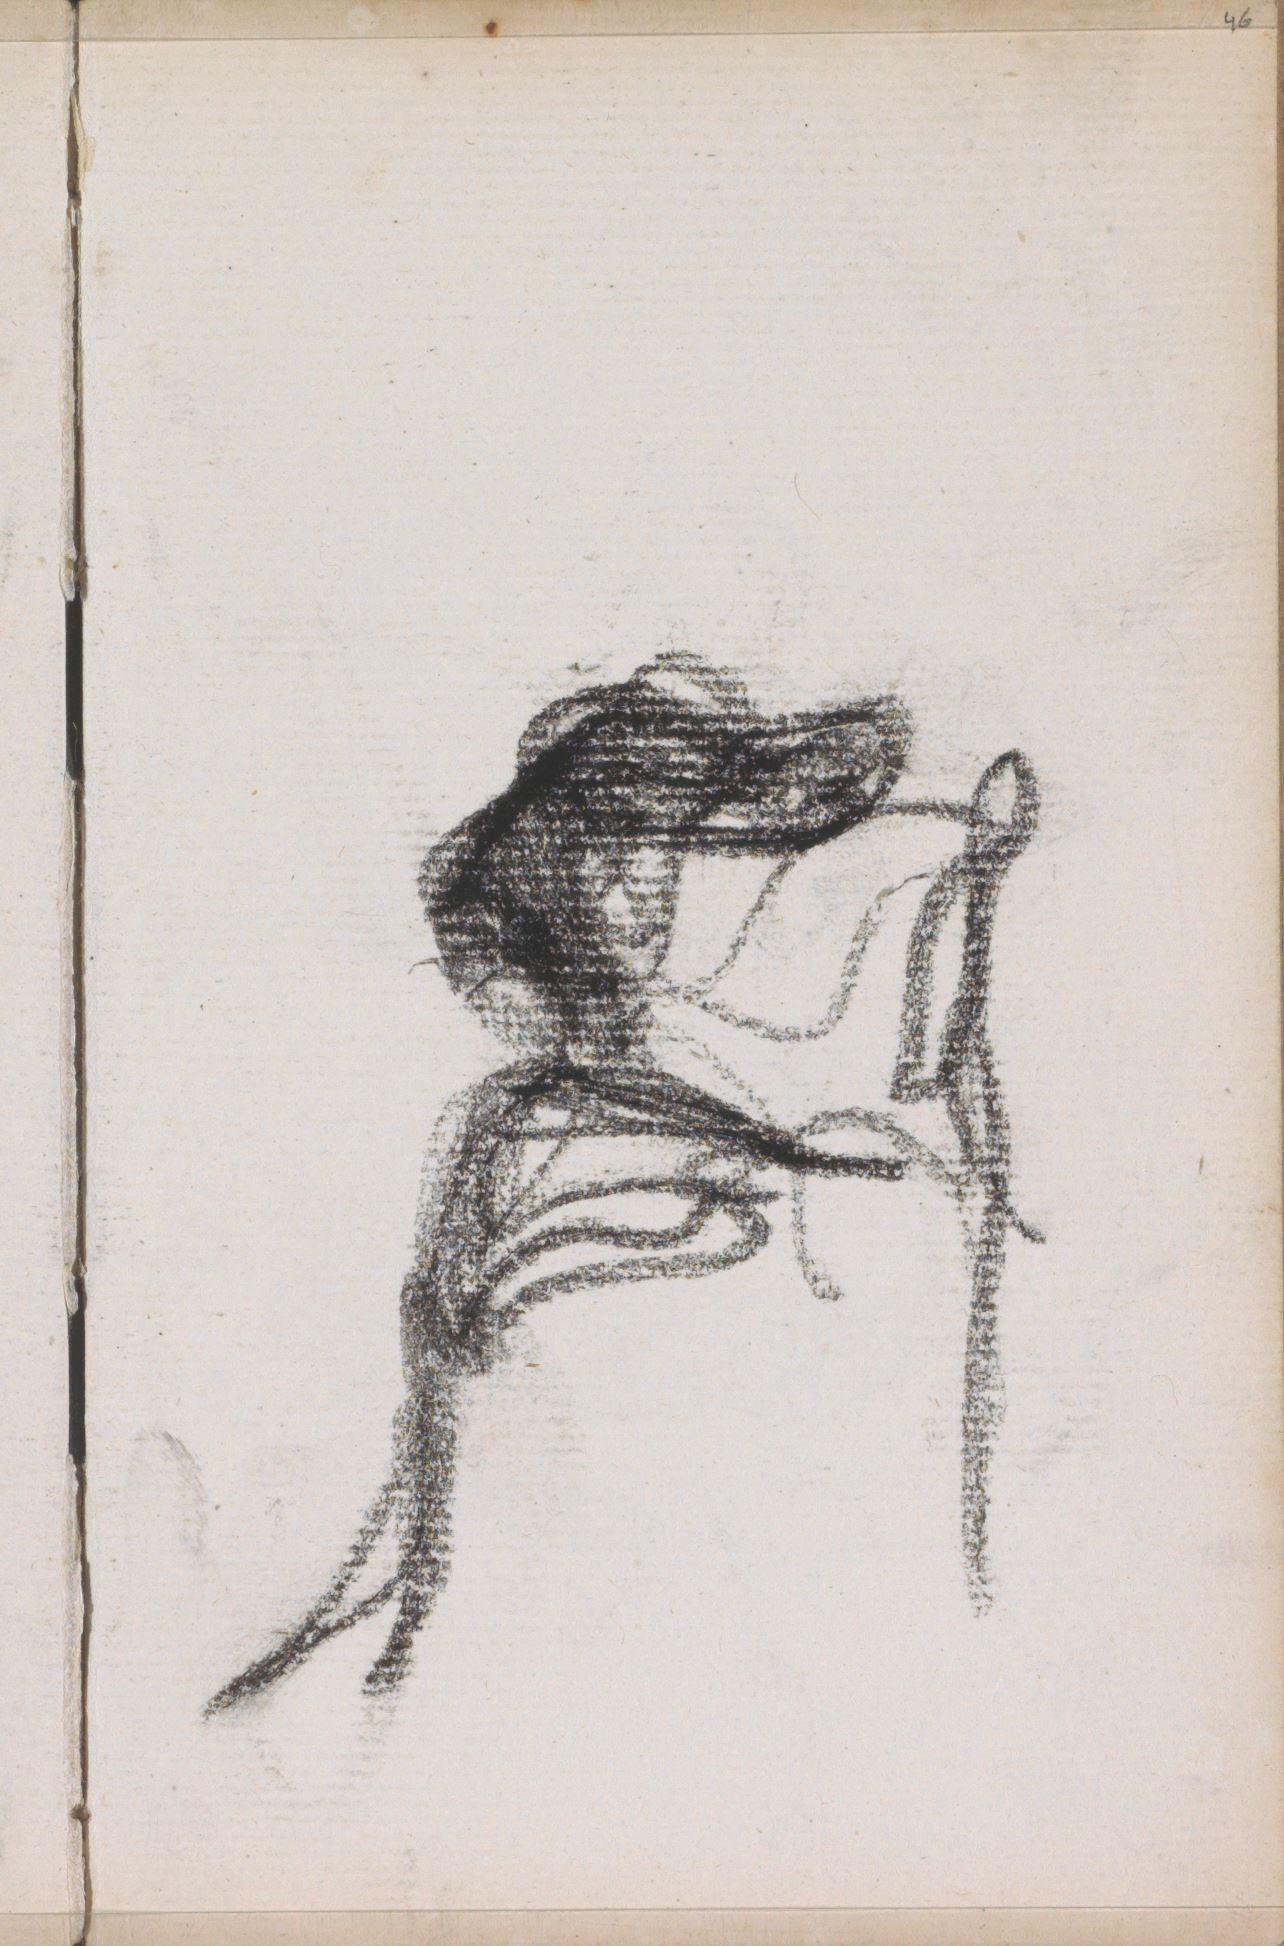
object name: sketchbook leaf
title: Studie, mogelijk van een koe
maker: george hendrik breitner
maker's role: draughtsman, painter, print maker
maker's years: 1857-1923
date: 1884-1886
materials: chalk, paper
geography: drenthe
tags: cow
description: Pagina 46 uit een schetsboek met 67 bladen vervaardigd in Drenthe.